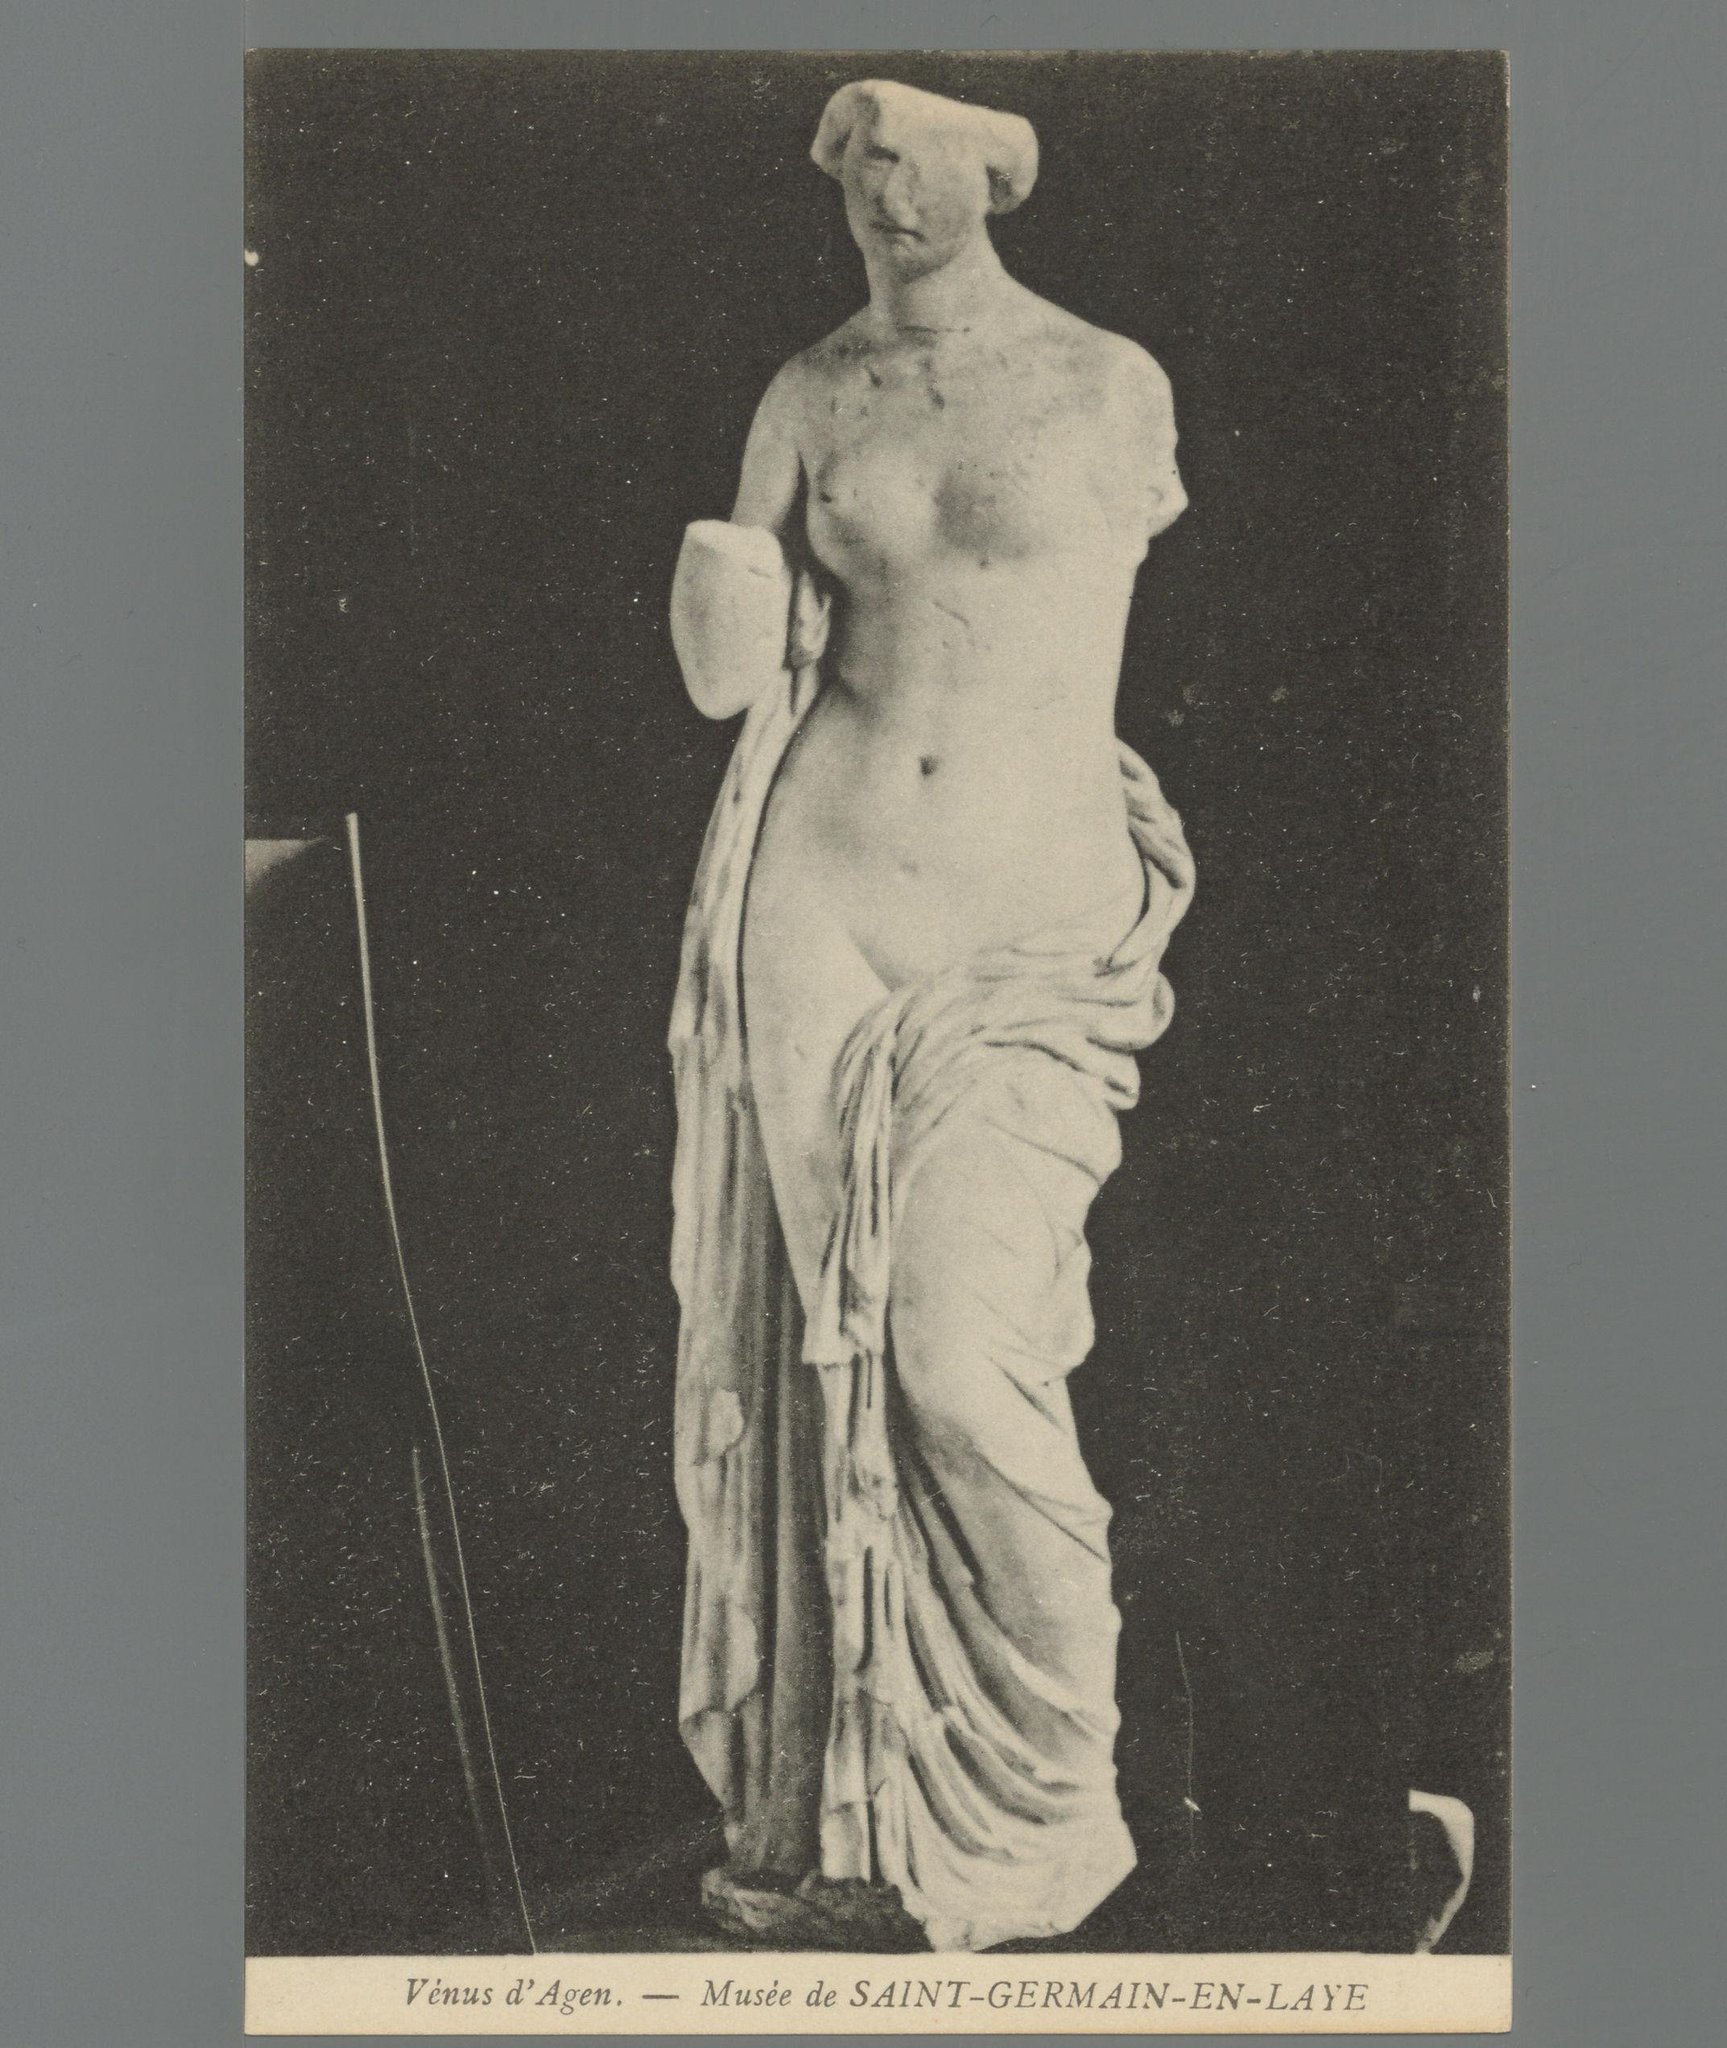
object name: photomechanical print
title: Musée de Saint-Germain-en-Laye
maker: Anonymous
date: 1903-1920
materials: cardboard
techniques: photograph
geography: saint-germain-en-laye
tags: monument, statue, permanent exhibition, museum